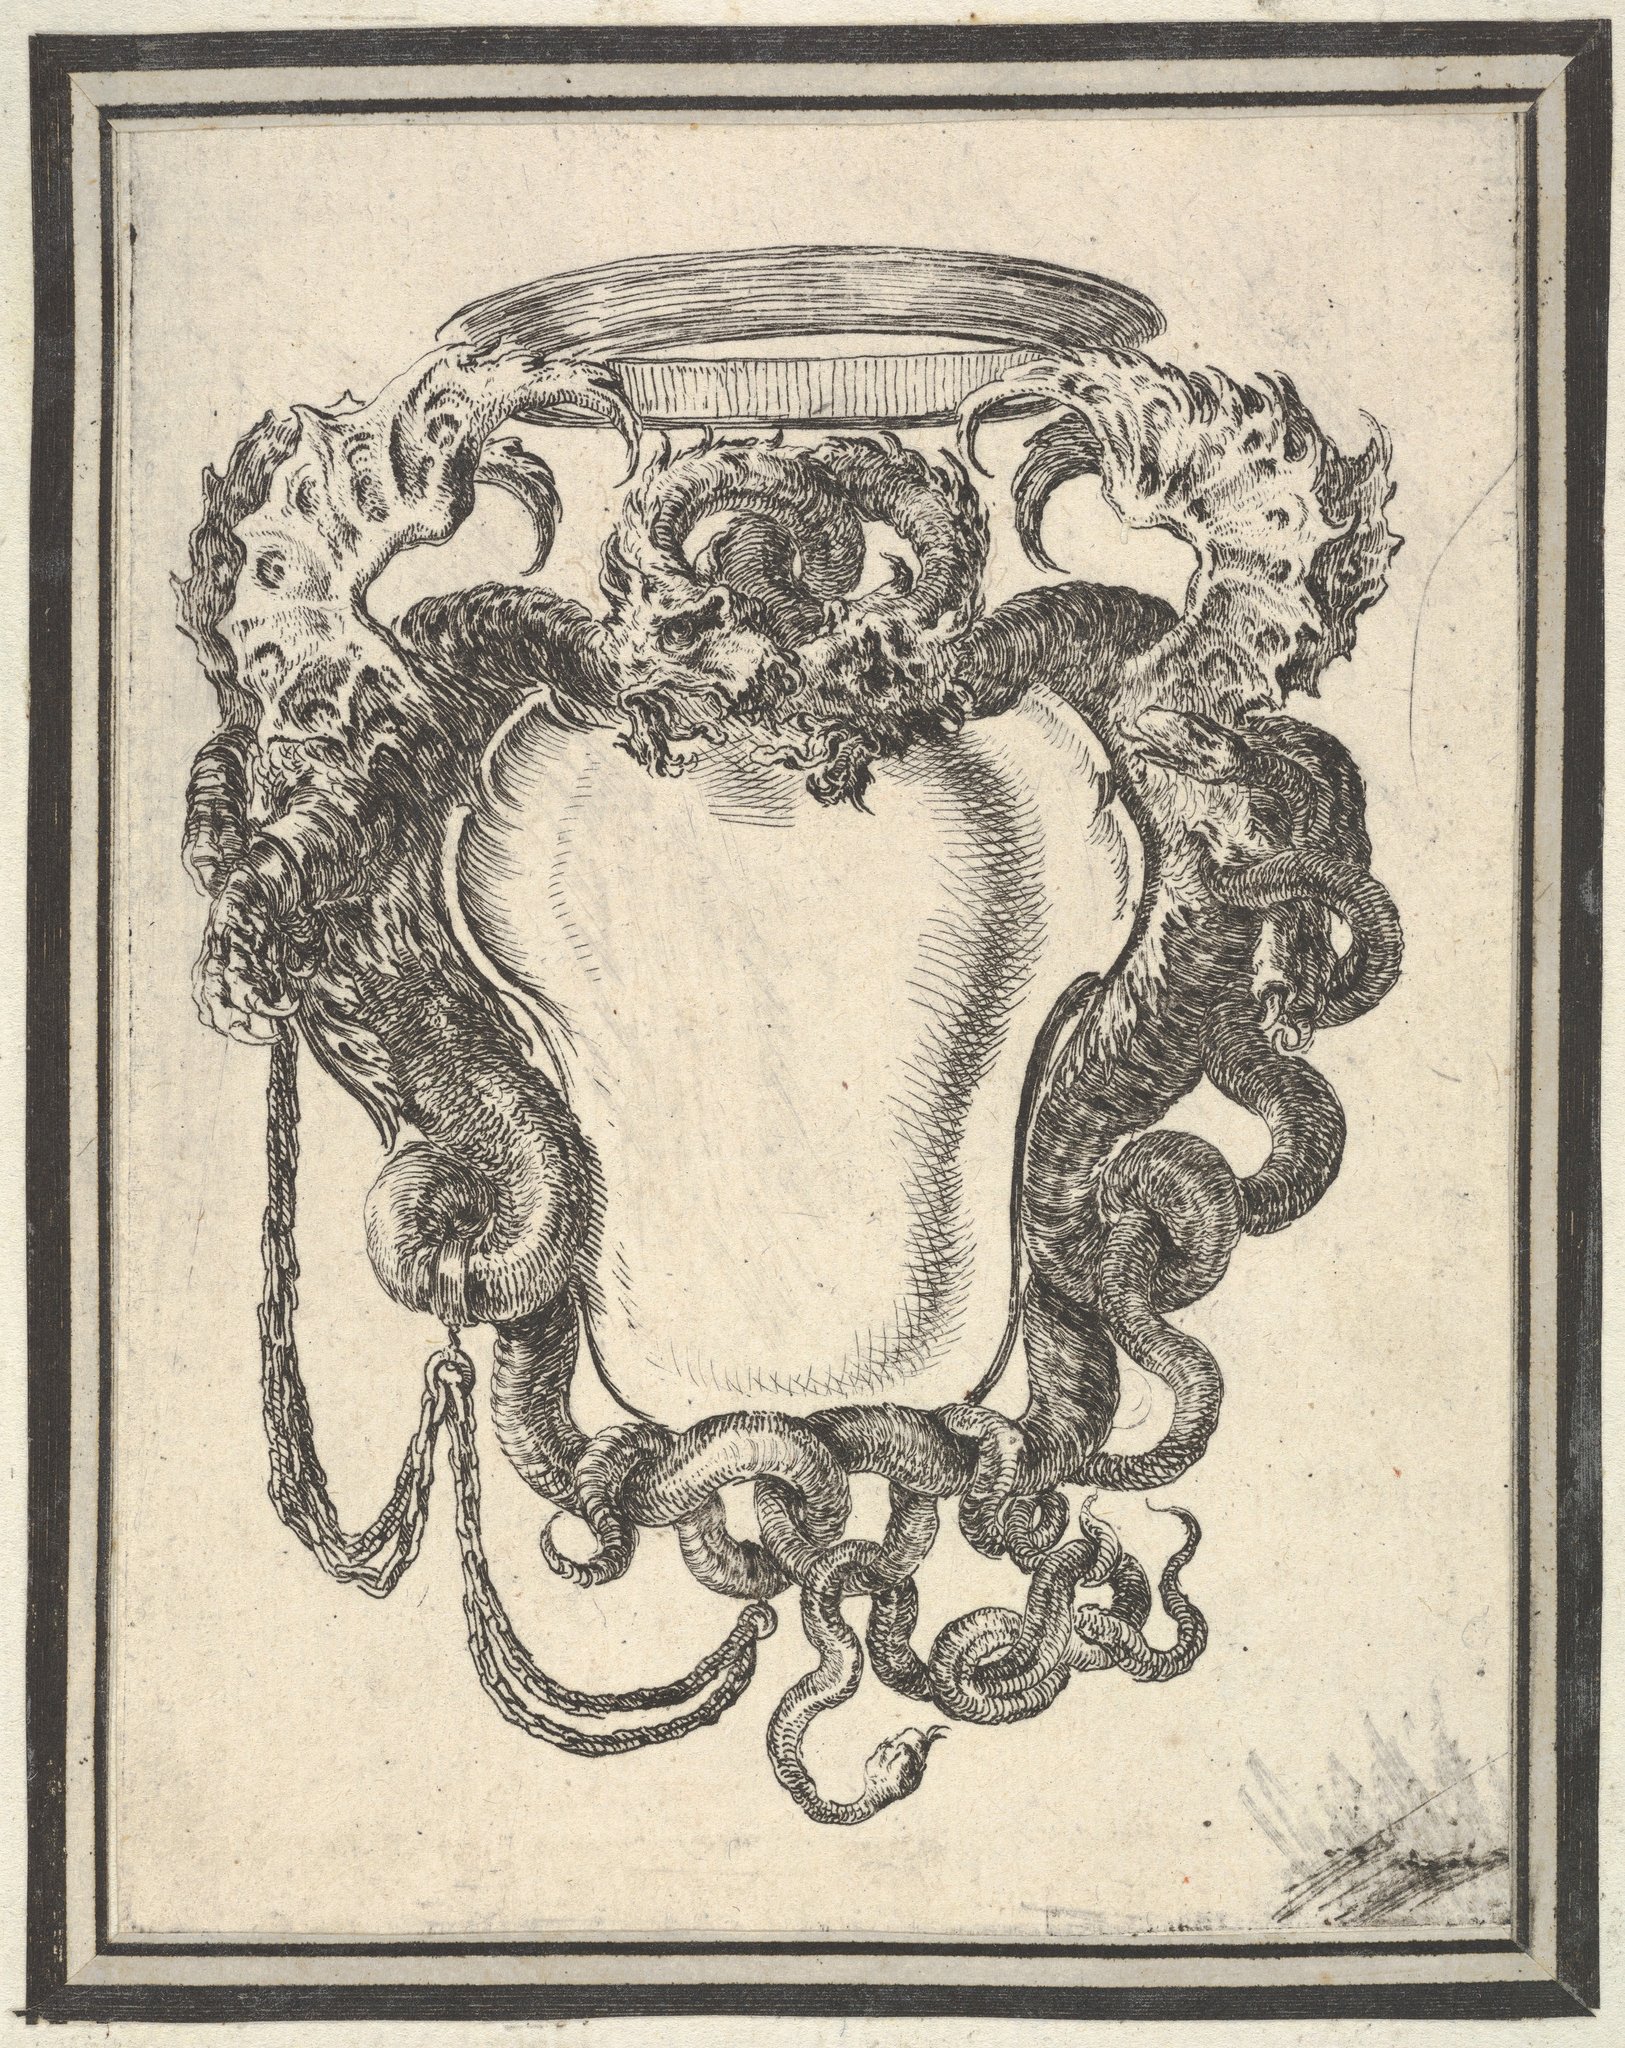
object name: print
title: A cartouche flanked by dragons, their tails supporting a crown at top, plate 8 from "Nouvelles inventions de Cartouches"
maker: stefano della bella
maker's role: artist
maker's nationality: italian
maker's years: 1610-1664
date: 1647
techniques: etching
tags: cartouches,dragons